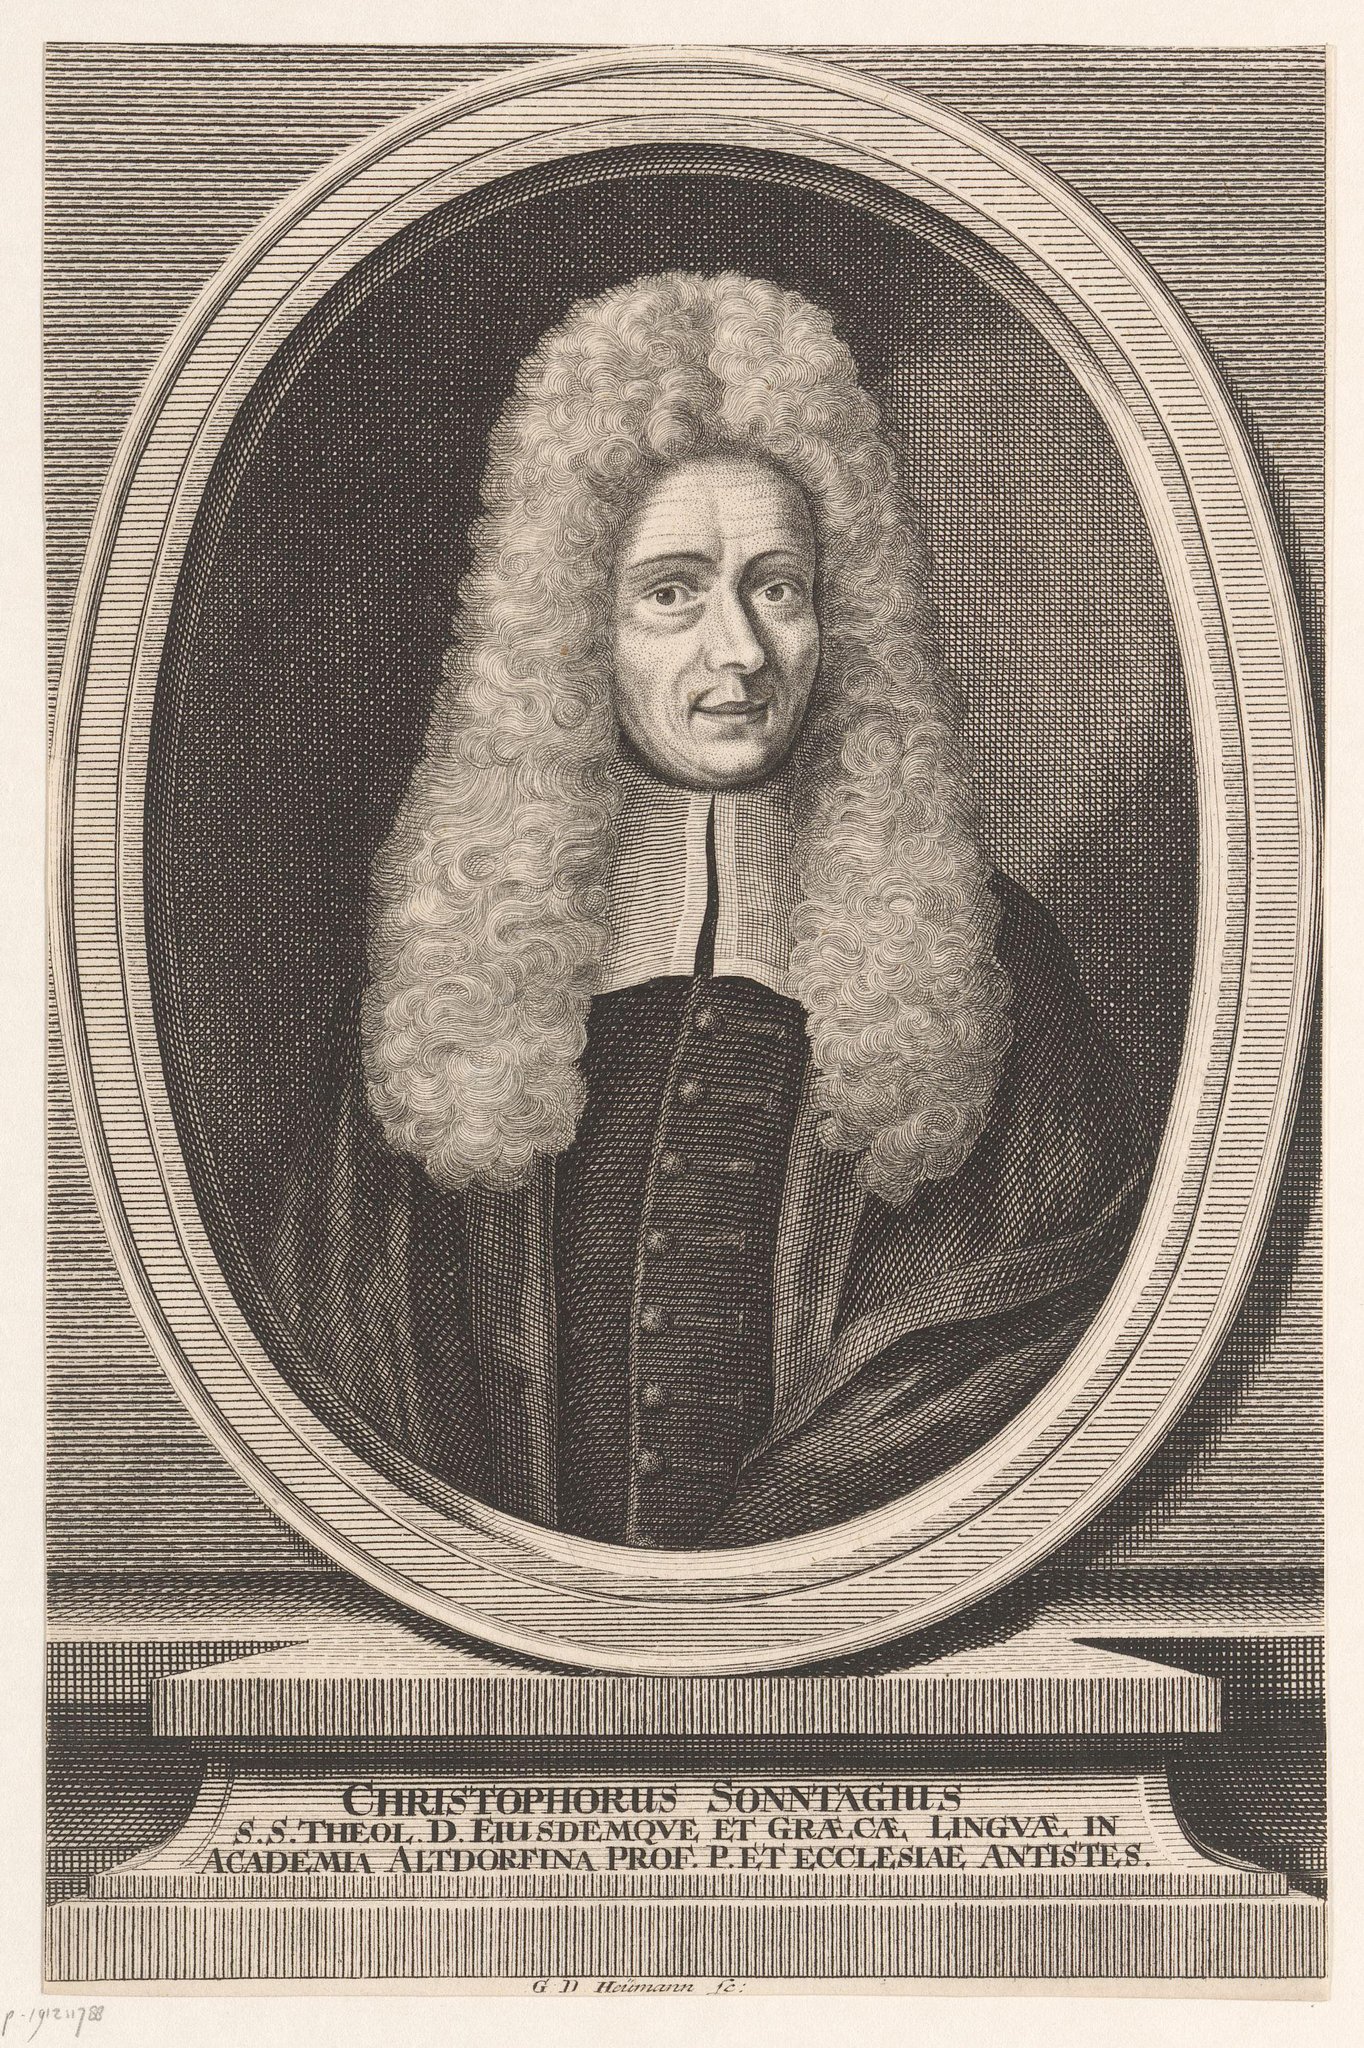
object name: print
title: Portret van Christoph Sonntag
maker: georg daniel heumann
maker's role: print maker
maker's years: 1691-1759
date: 1701-1759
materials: paper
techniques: engraving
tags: christoph sonntag, theologian, historical persons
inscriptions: collector's mark: Lugt 2228